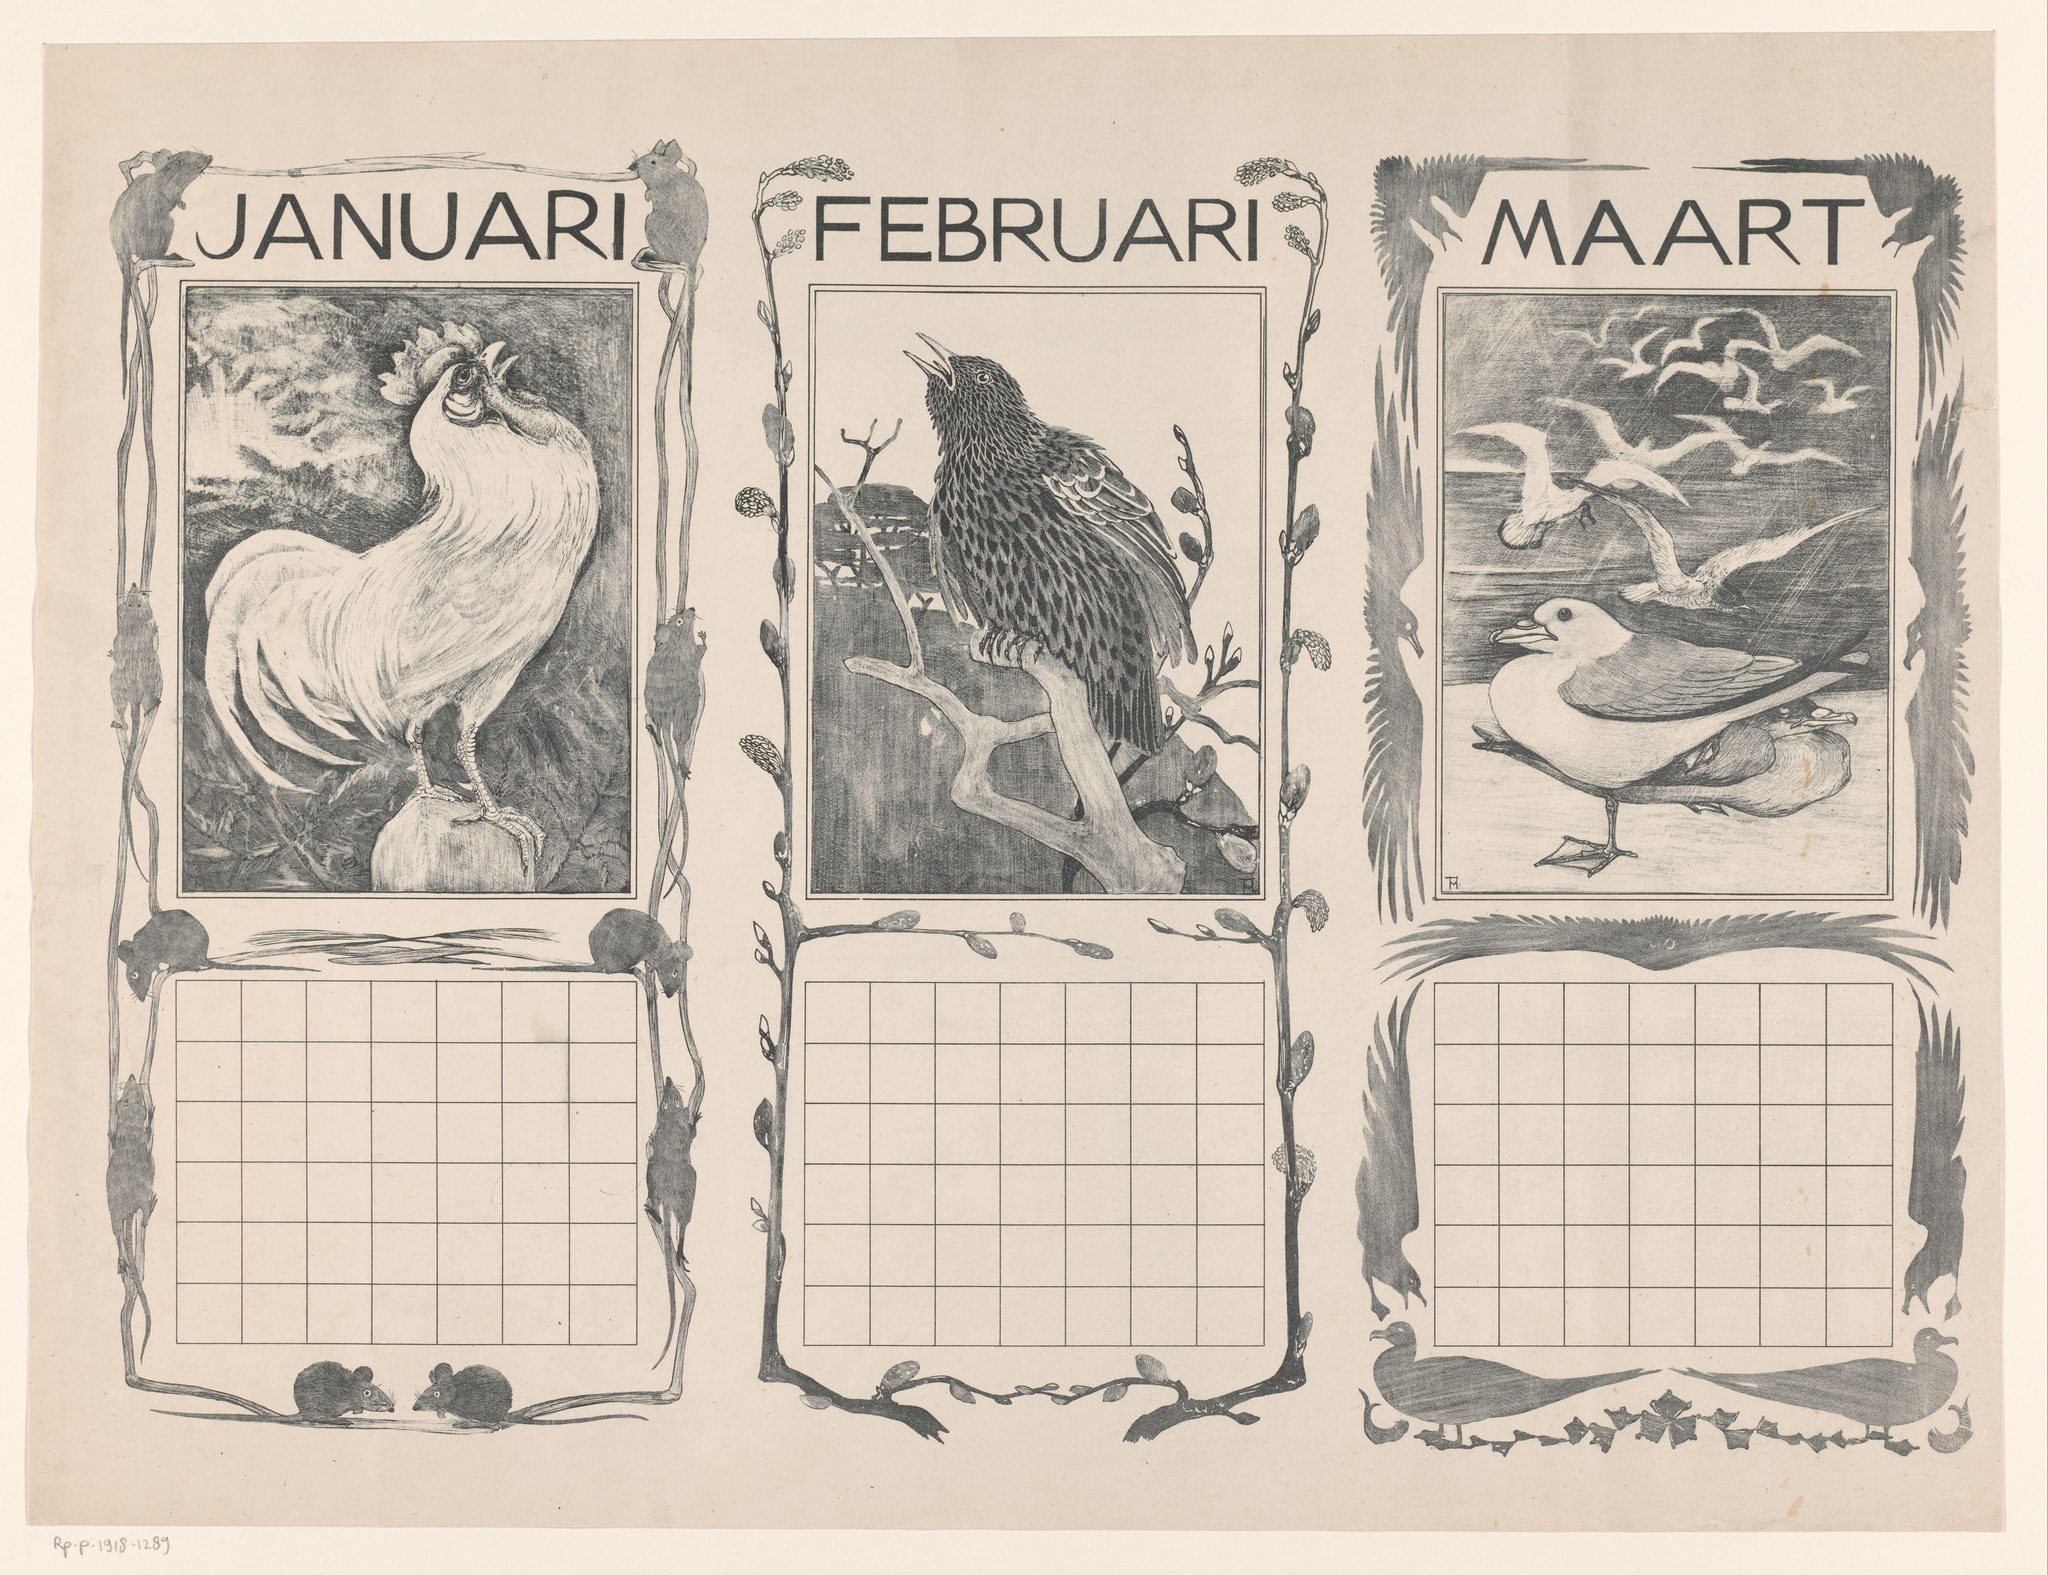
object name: print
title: Kalenderbladen van januari, februari en maart, met vogels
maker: theo van hoytema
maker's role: draughtsman, painter, print maker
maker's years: 1863-1917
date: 1901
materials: paper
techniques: lithograph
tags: calendar, almanac, birds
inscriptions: collector's mark: Lugt 2233